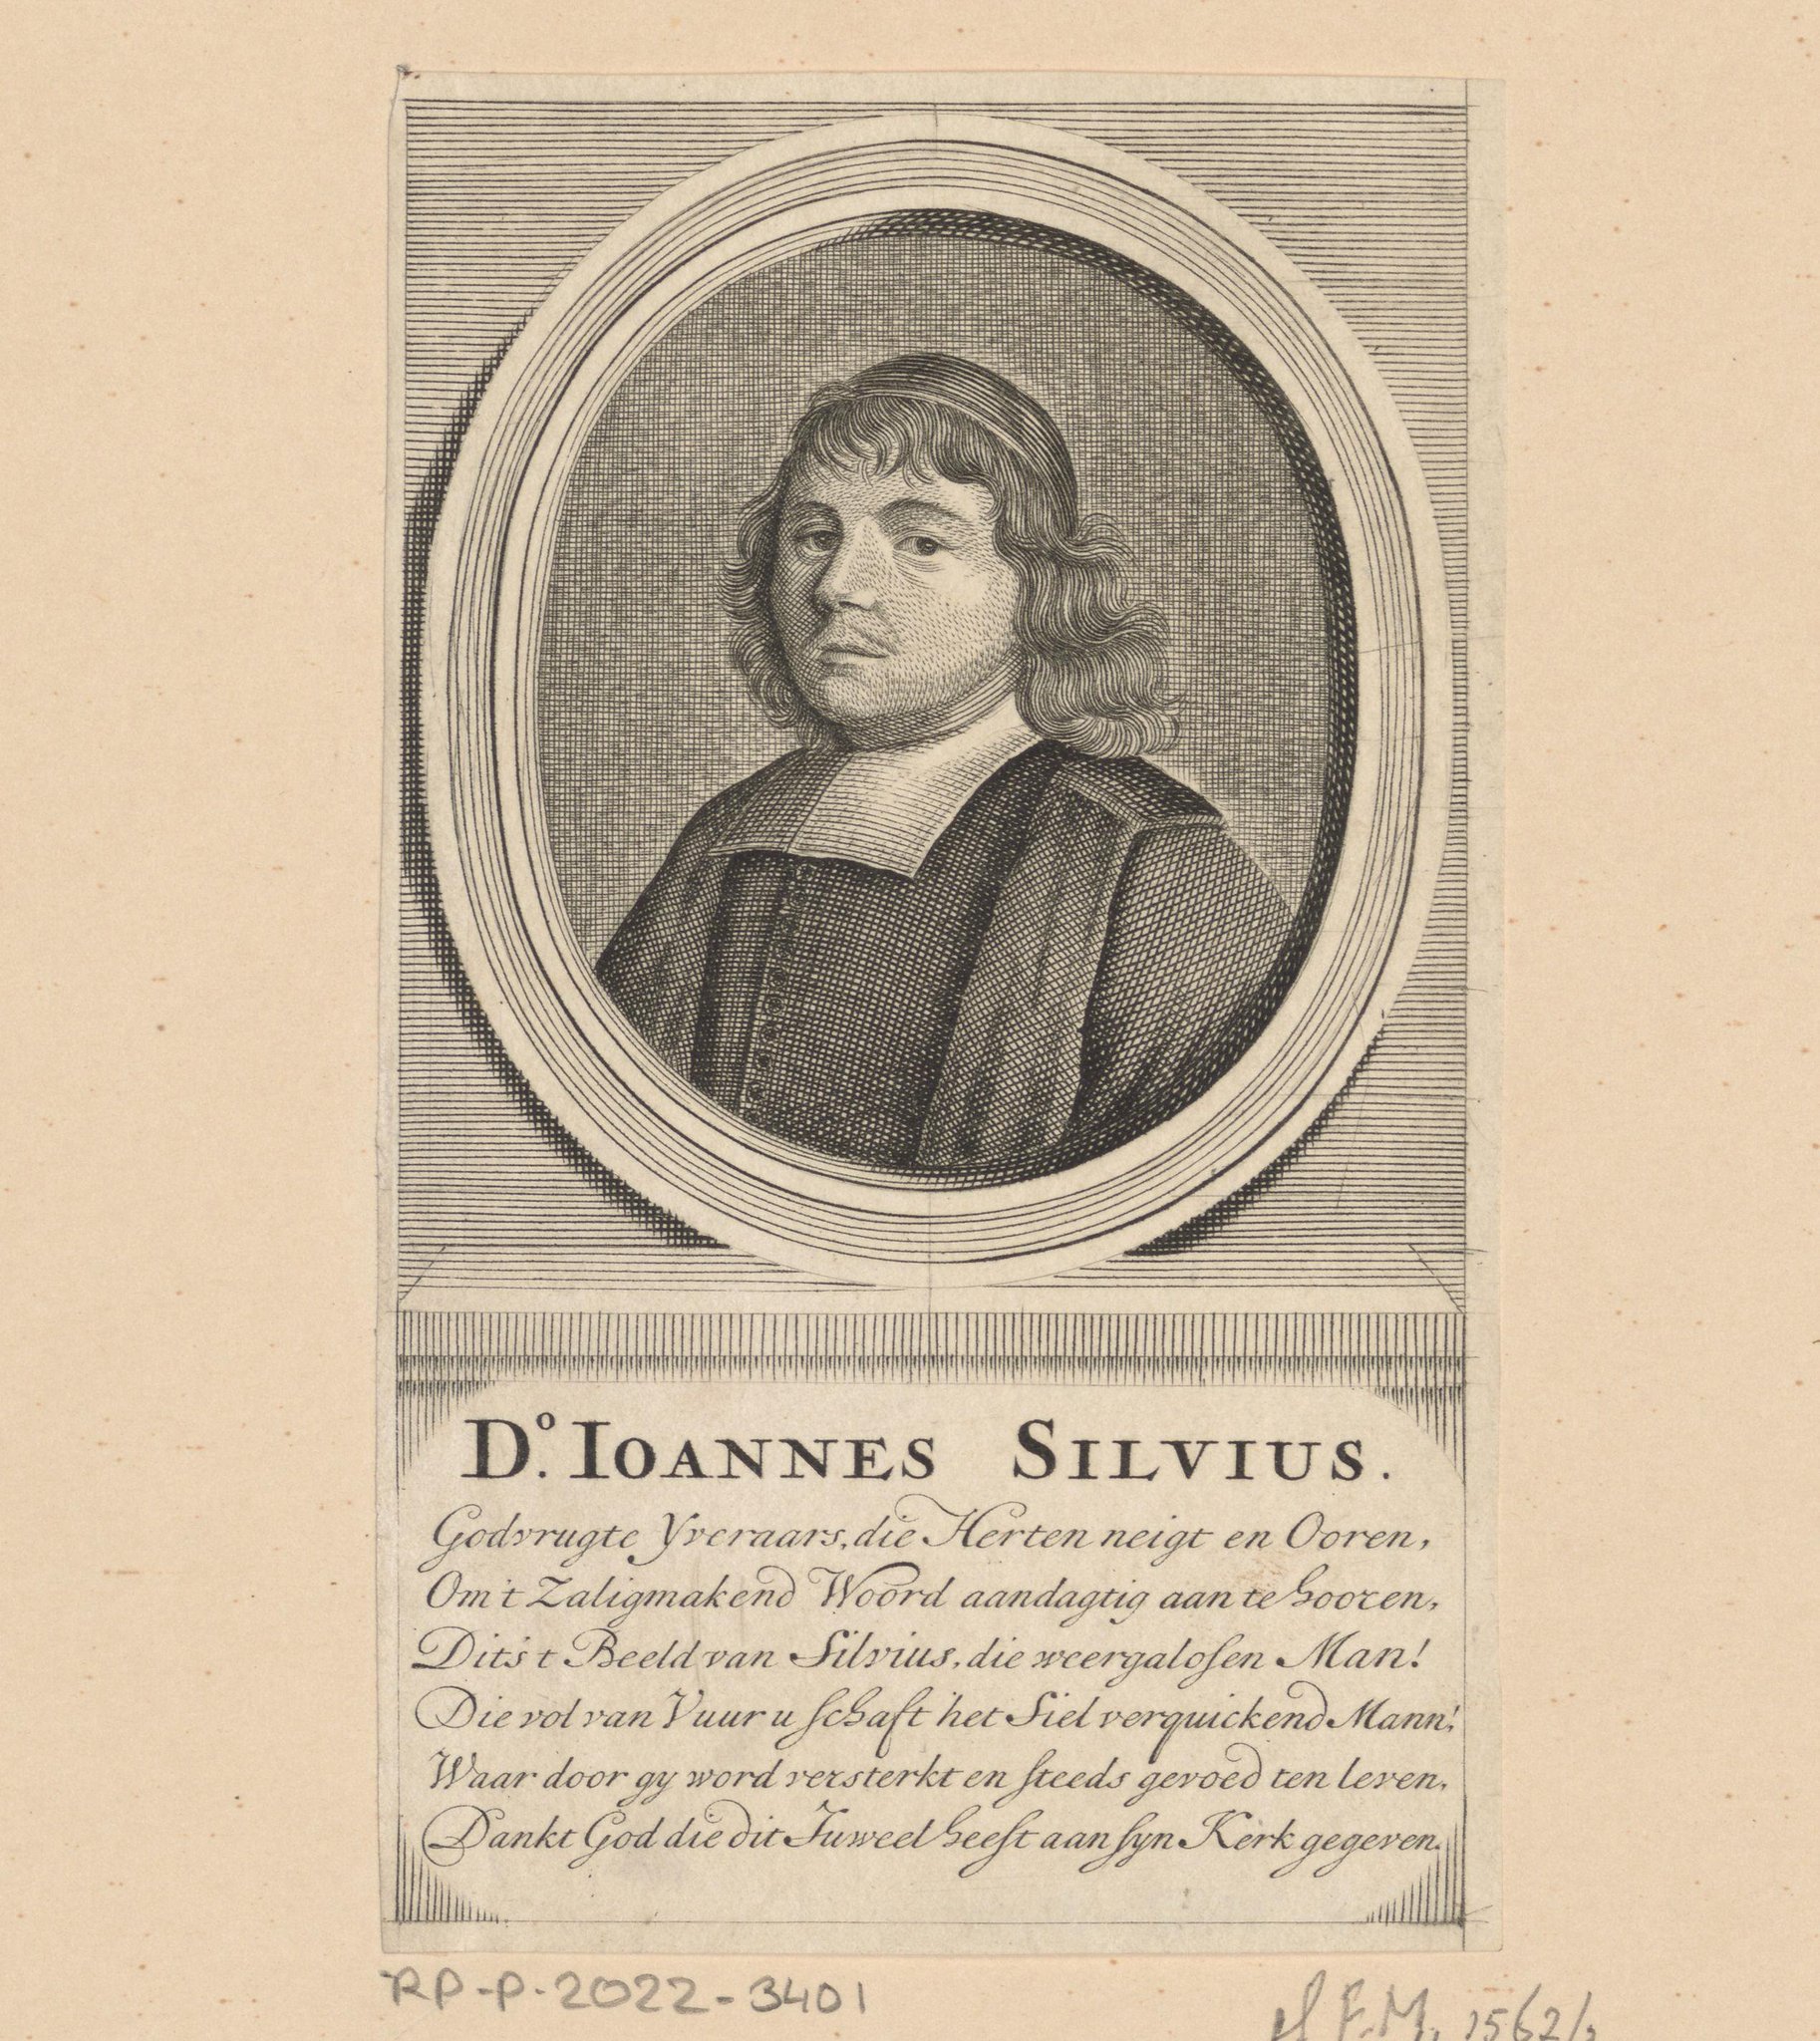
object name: print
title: Portret van Johannes Sylvius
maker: Anonymous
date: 1660-1720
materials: paper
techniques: engraving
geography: netherlands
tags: functionaries and dignitaries (with name) ~ protestant churches, historical persons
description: Onder het portret een zesregelig gedicht in het Nederlands.